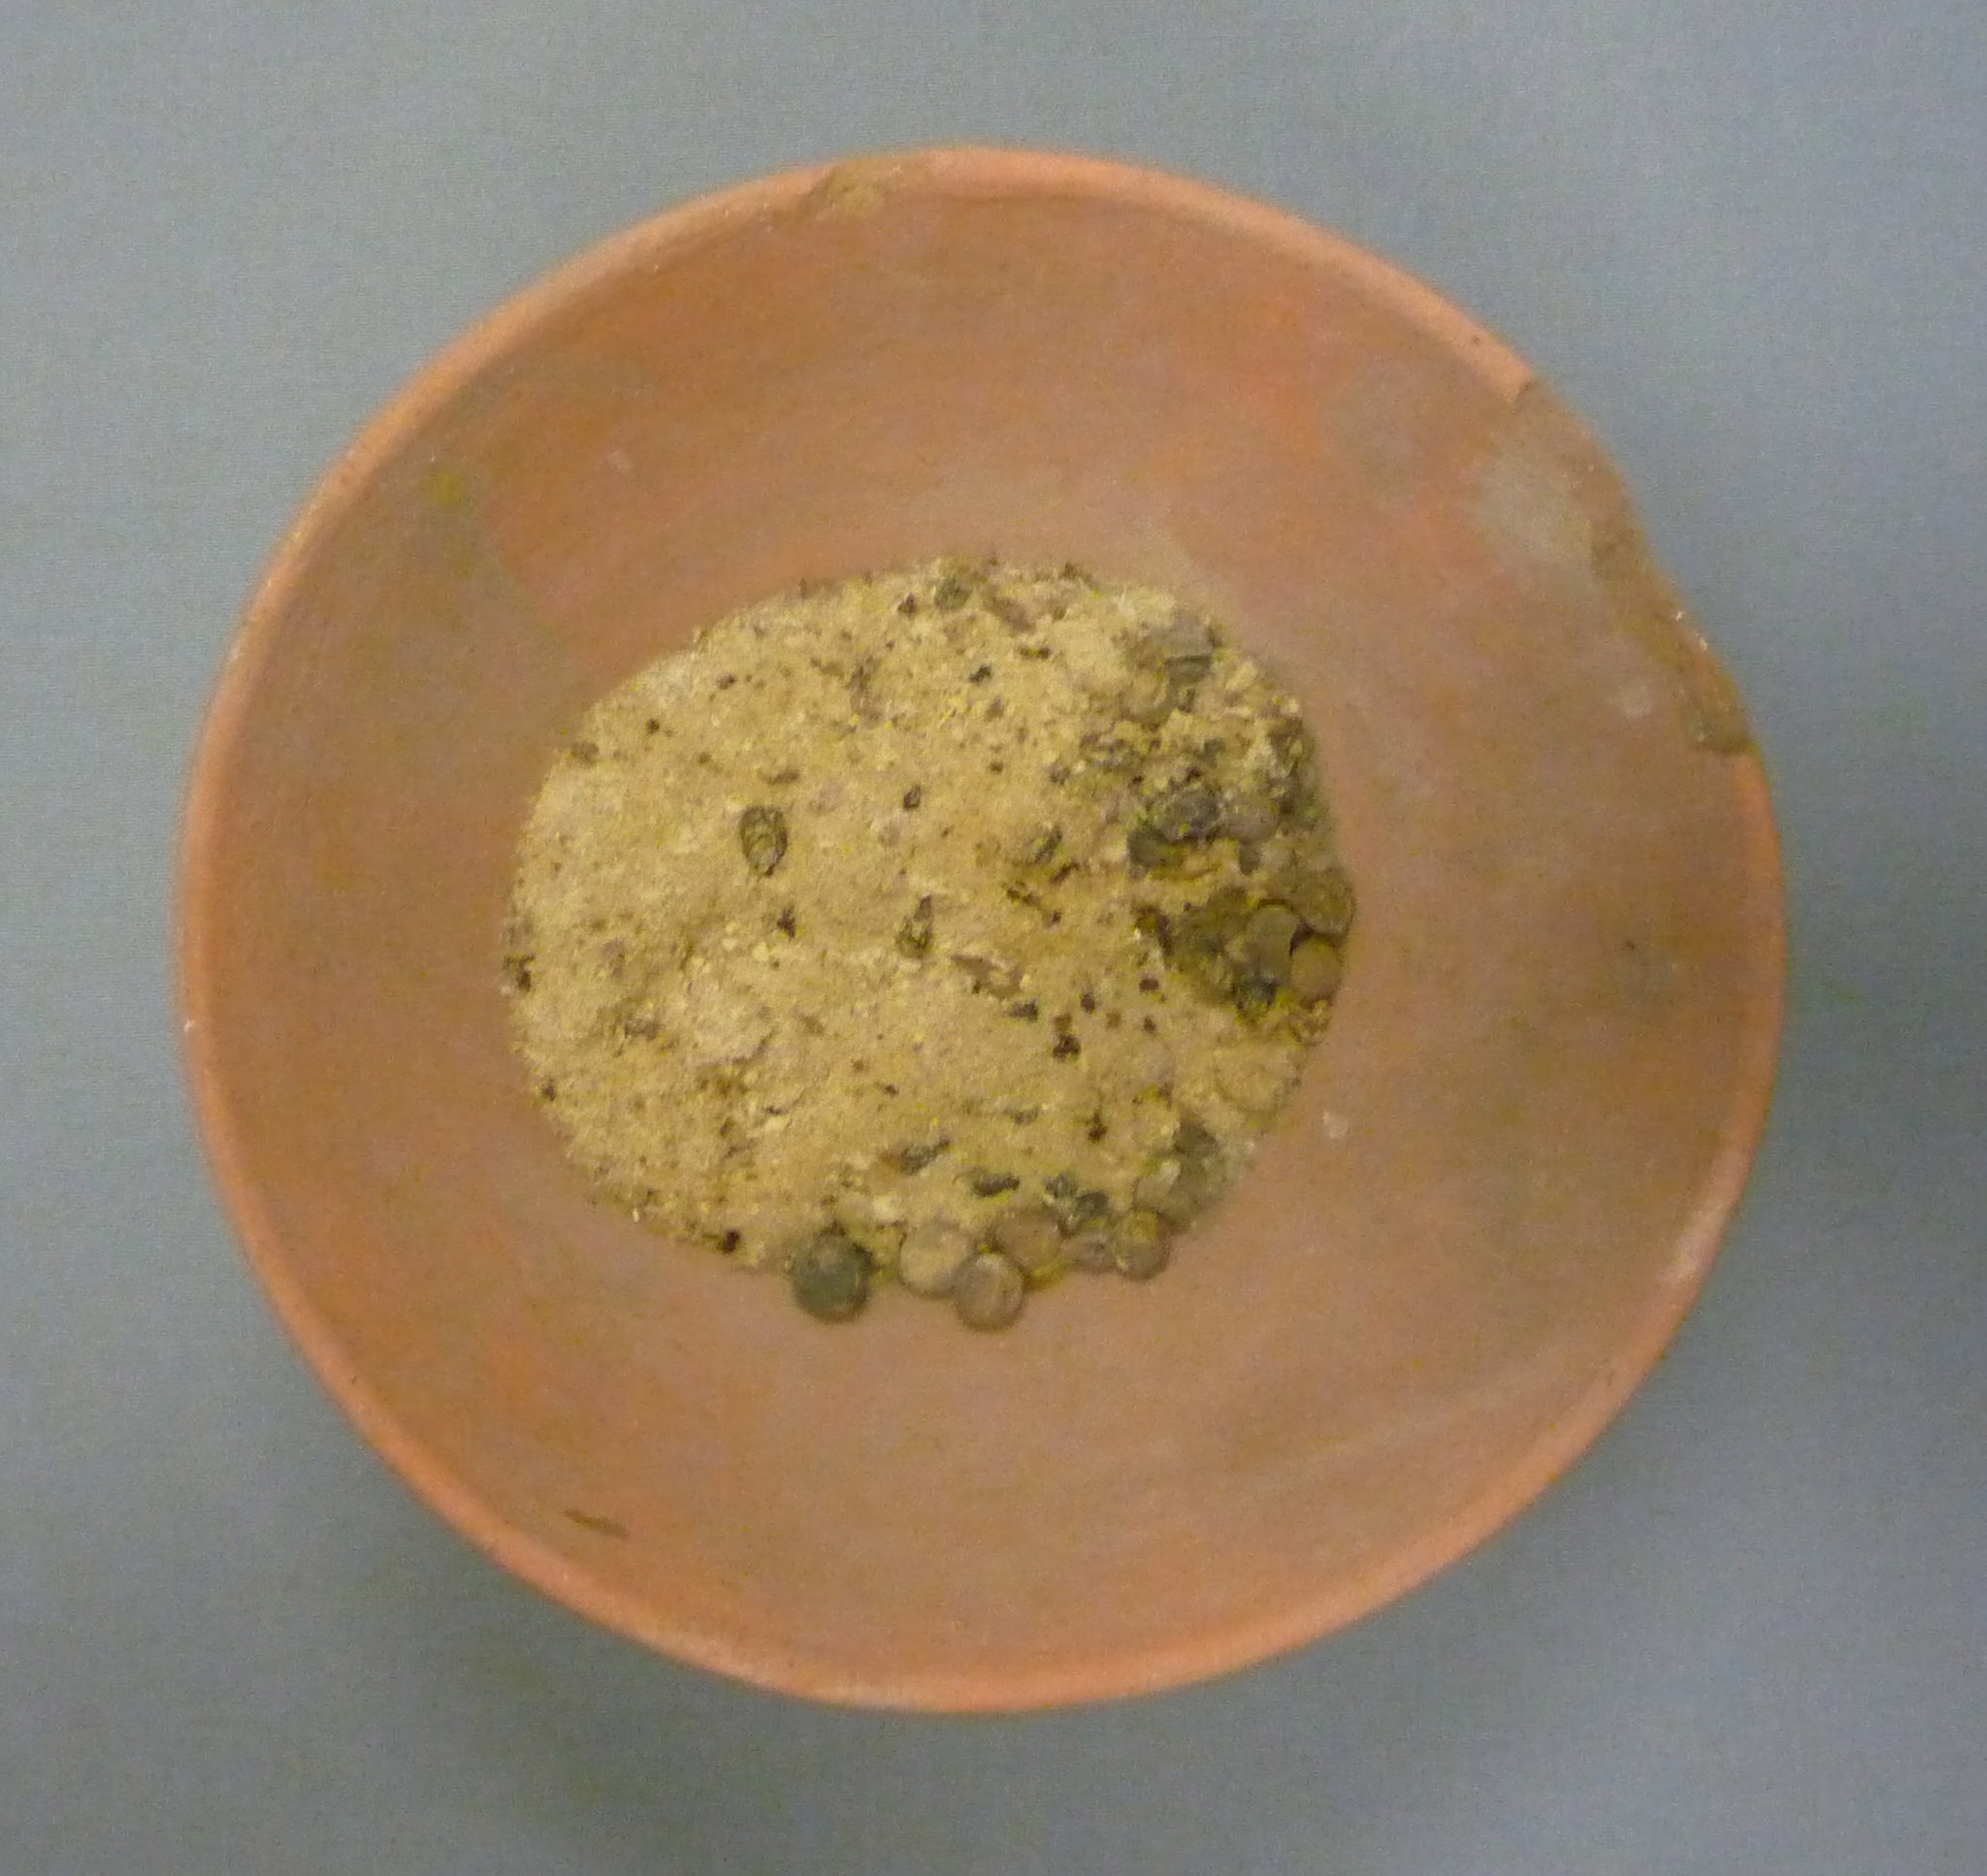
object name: bowl, jujube berry and sand, foundation deposit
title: Bowl of Jujube Berries and Sand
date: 1479-1458 BCE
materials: pottery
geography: egypt